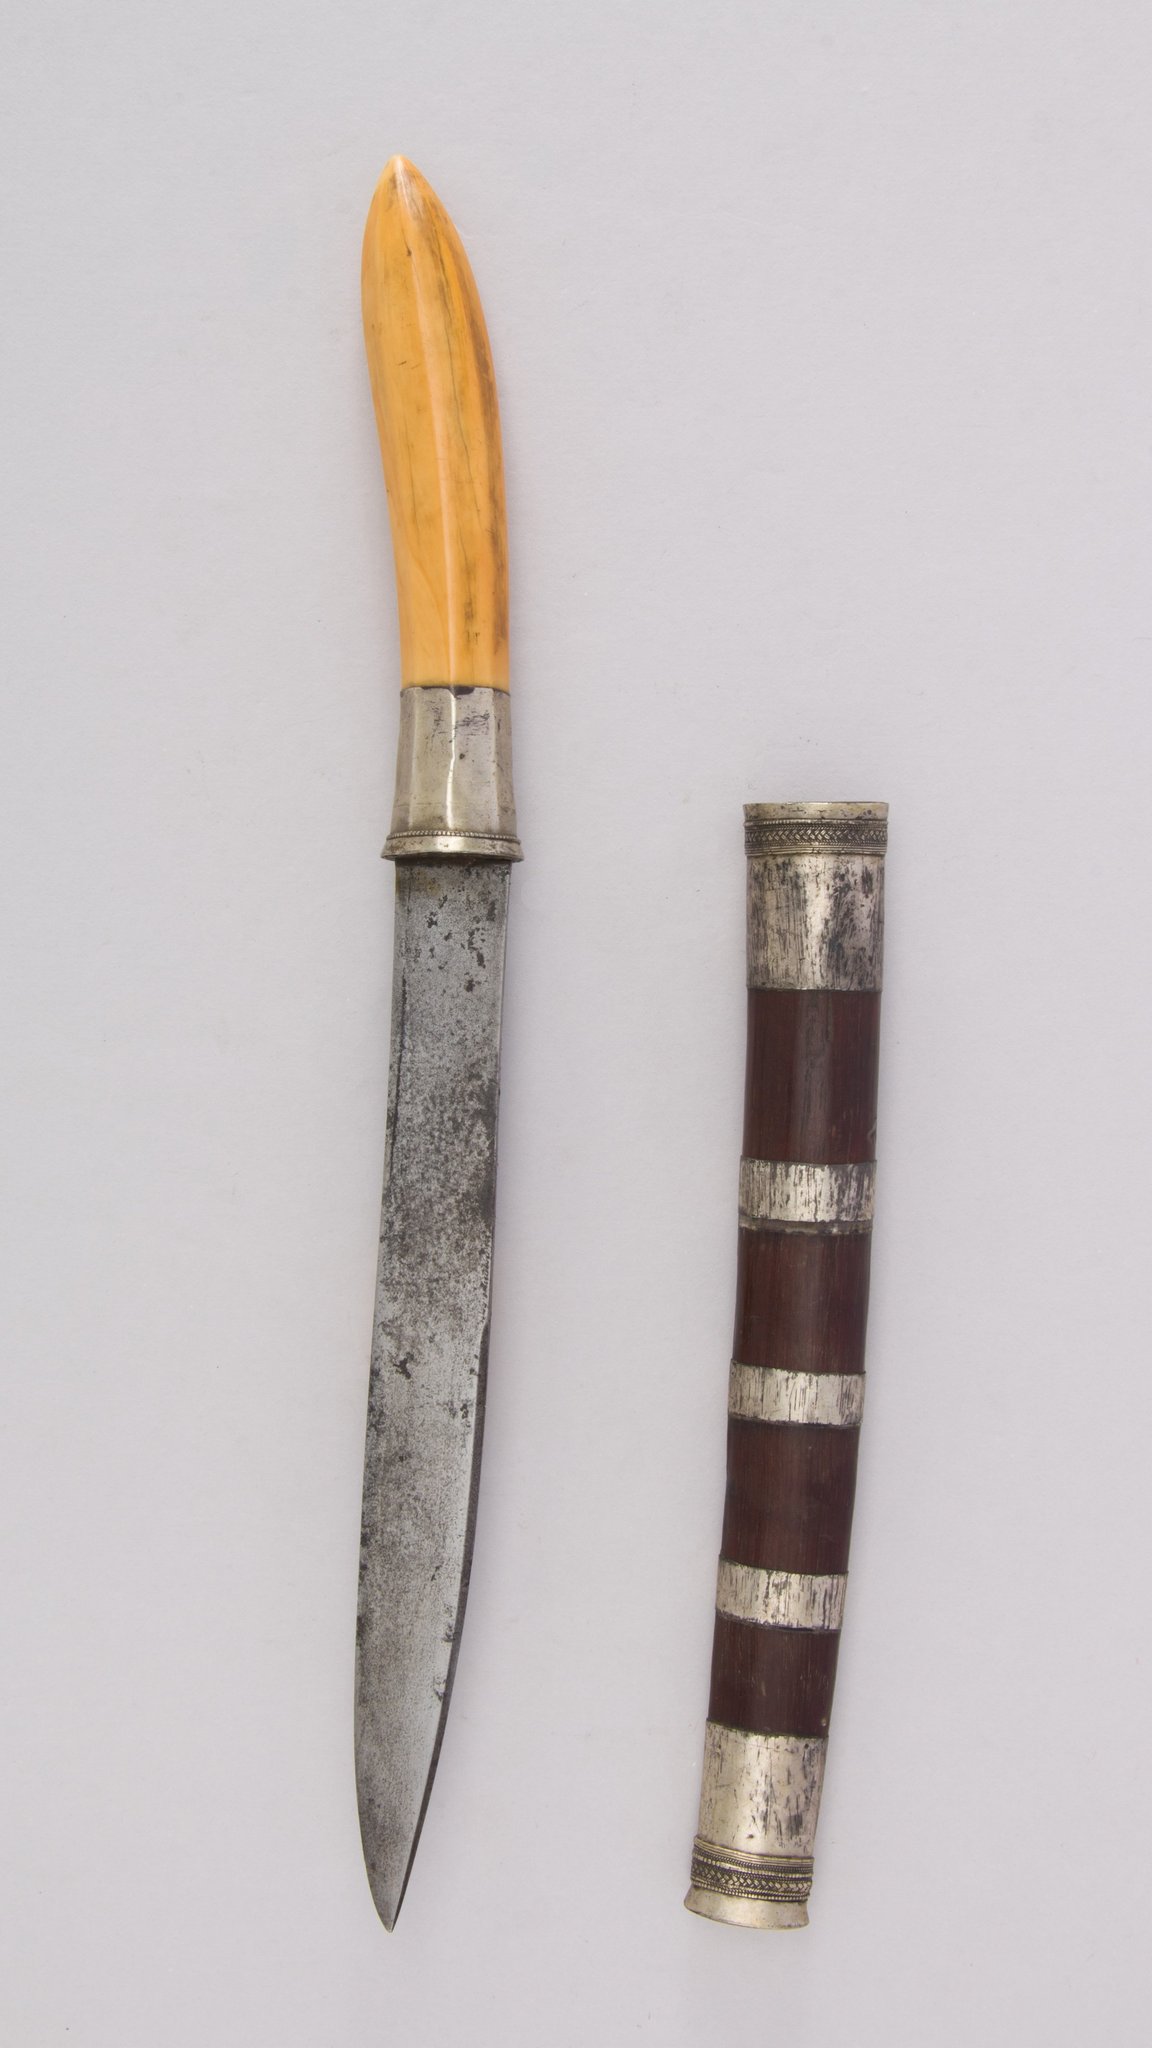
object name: knife dha with sheath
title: Knife (Dha) with sheath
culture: burmese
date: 1801-1900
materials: ivory, silver, steel, wood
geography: burma